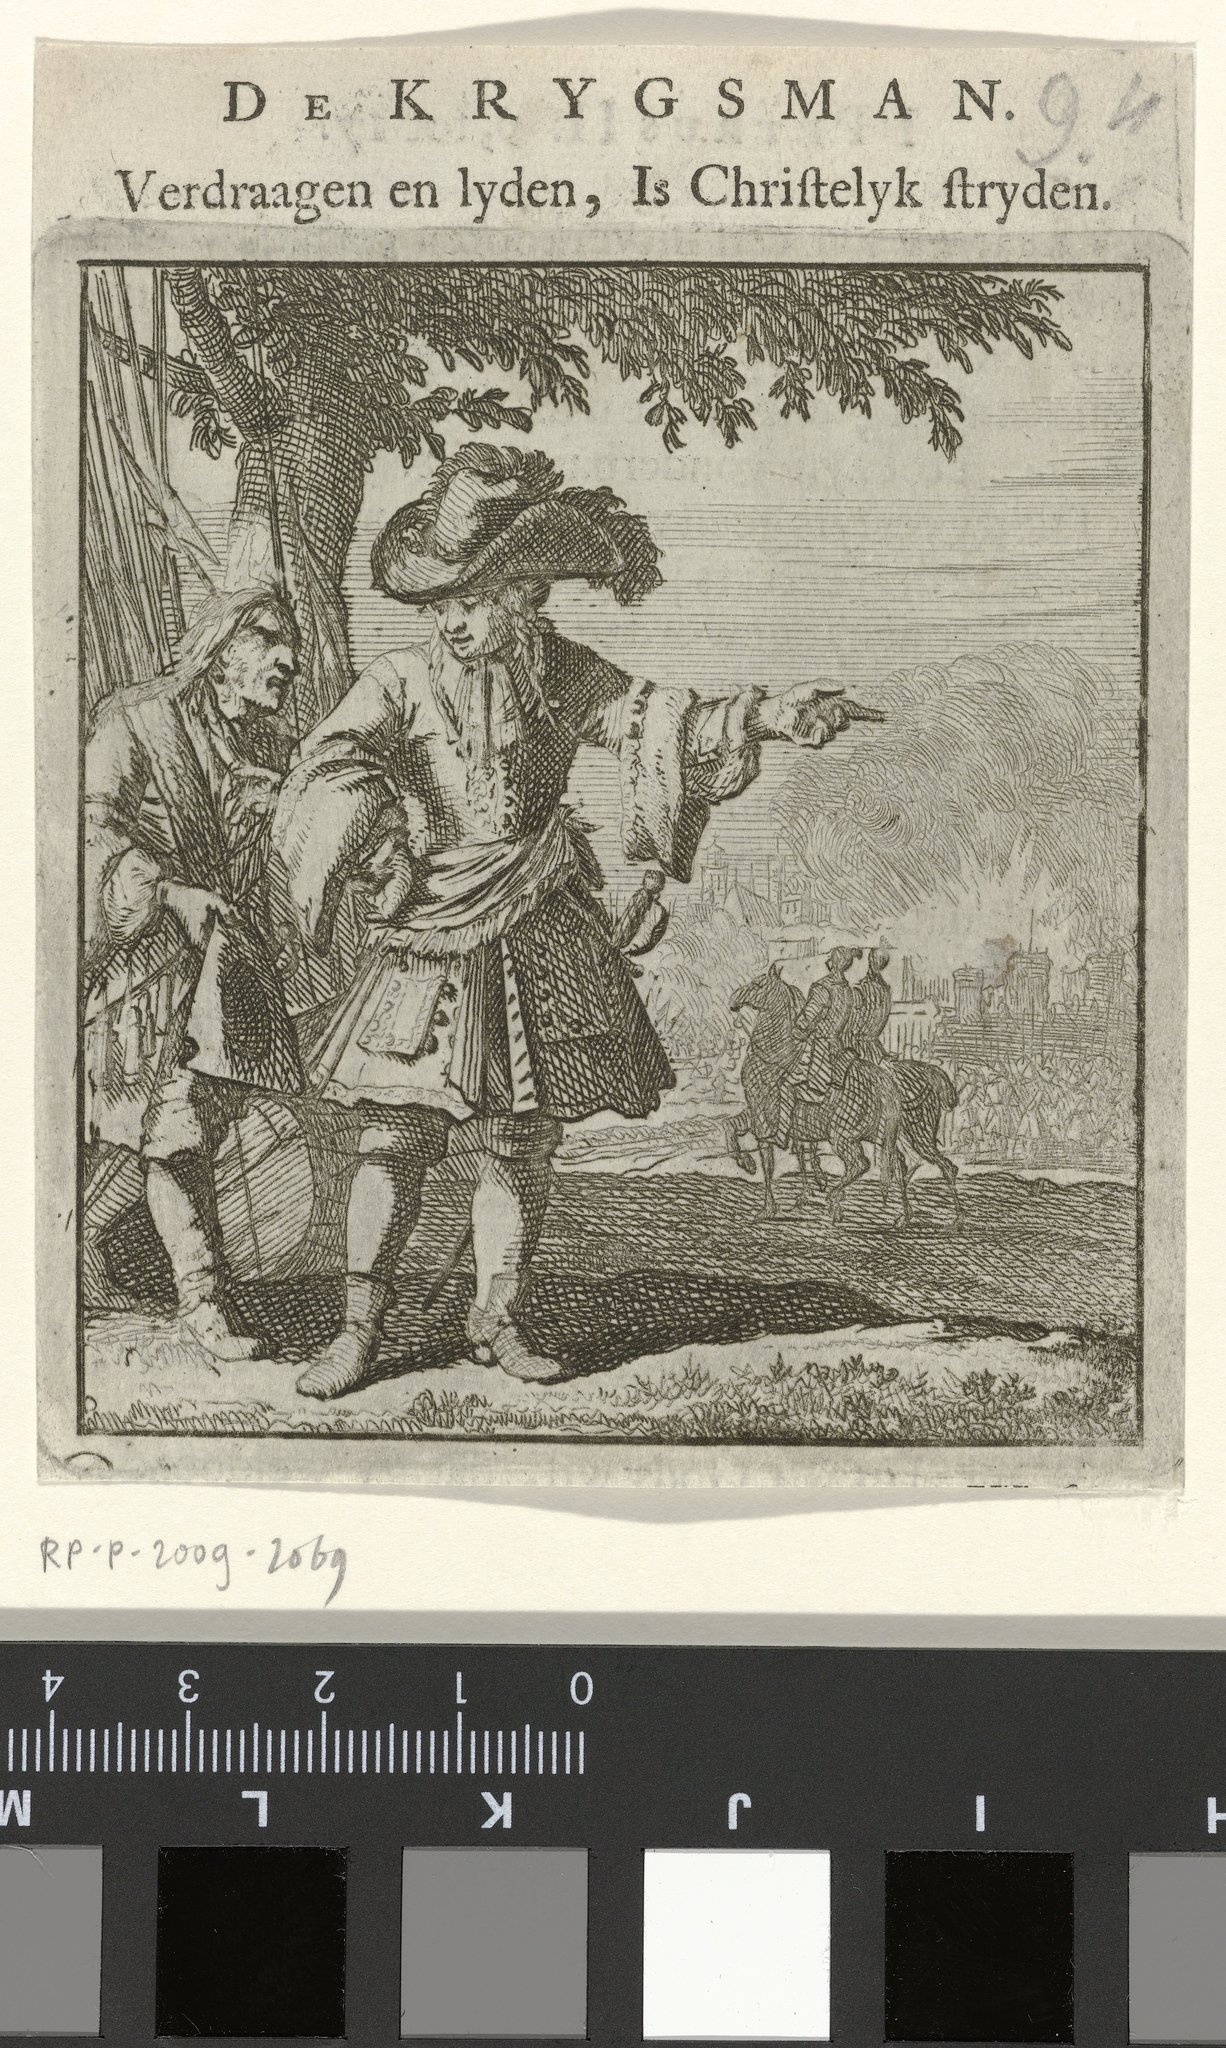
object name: print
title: Musketier en officier bij een boom met in de verte een gevecht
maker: jan luyken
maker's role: draughtsman, print maker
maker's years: 1649-1712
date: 1694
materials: paper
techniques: engraving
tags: head-gear: tricorn (+ men's clothes), riding a horse, ass, or mule; rider, horseman, shoulder-belt, bandoleer (+ men's clothes), coat (justaucorps) (+ men's clothes), battle, the soldier; the soldier's life, trousers, breeches, etc. (breeches) (+ men's clothes)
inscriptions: inscription: ‘I petrus II: 9, tot 17. Maar gy zyt een uitverkooren geslacht, een koninglyk priesterdom, een heilig volk, een verkreegen volk...(etc)’, title: ‘De krygsman. Verdraagen en lyden, Is Christelyk stryden.’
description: Twee mannen bij een boom. De man links draagt een justaucorps en om de schouder een bandelier met kruitmaatjes. Zijn hoed in de hand. Rechts een man gekleed in een justaucorps, sjerp met franjes om het middel, degen aan de zijde. Hoed met veren op het hoofd. Op de achtergrond twee ruiters te paard, in de verte een gevecht bij een stad. De prent maakt deel uit van een bundel etsen van diversen ambachten genaamd Spiegel van het Menselyk Bedryf, door Jan Luyken, Amsterdam, 1694.